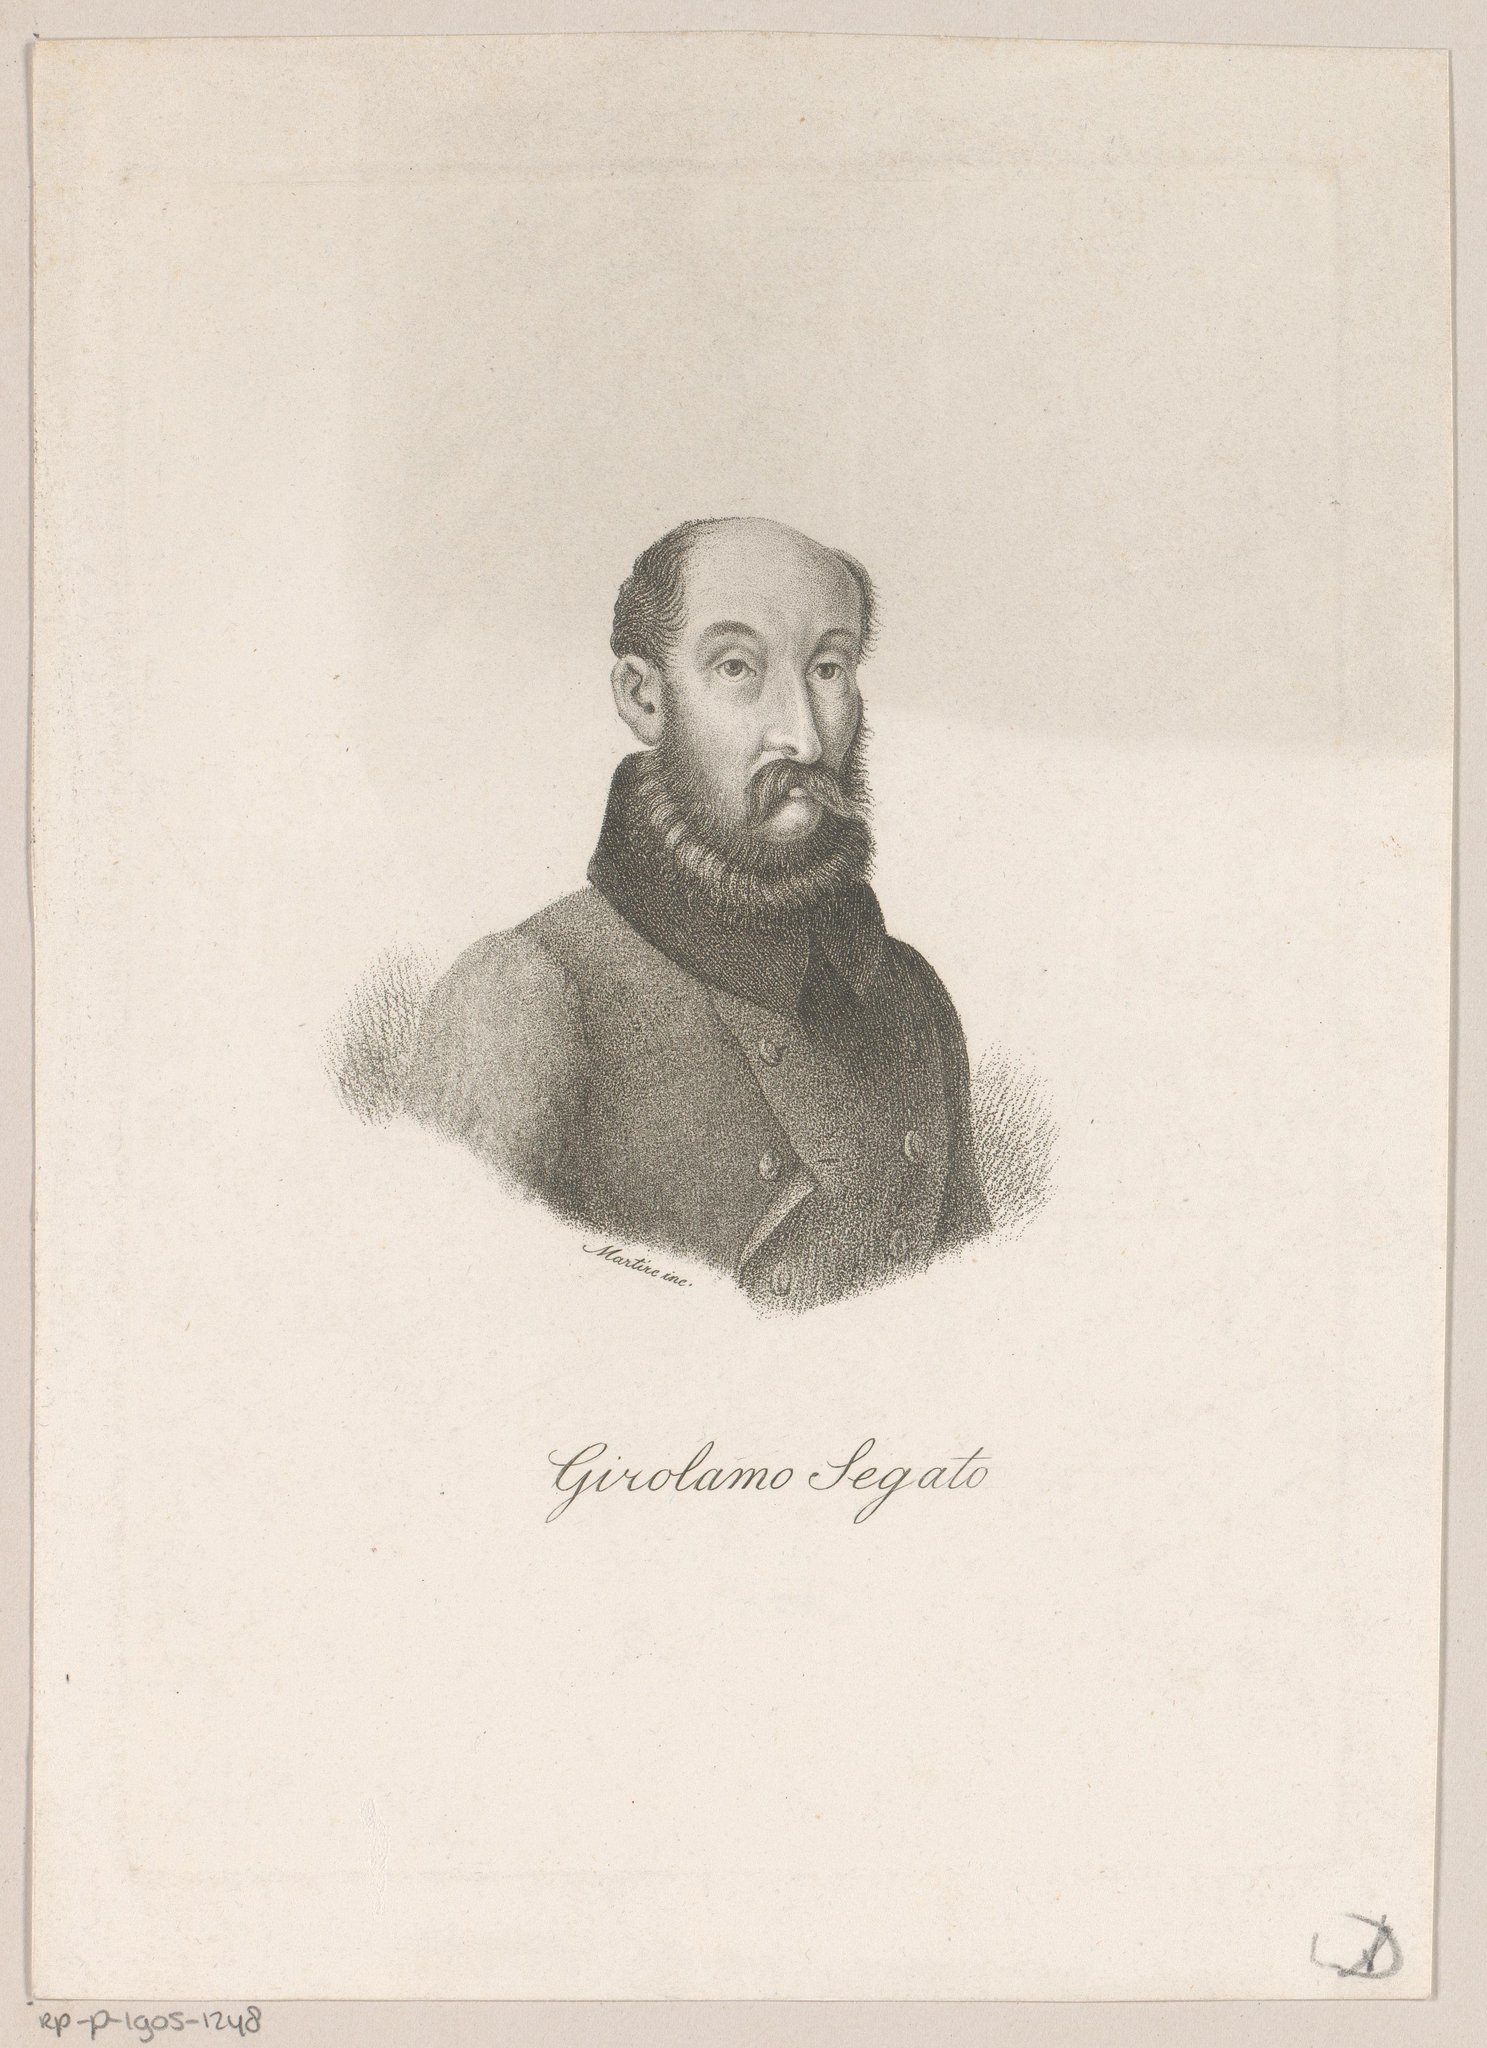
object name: print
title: Portret van Girolamo Segato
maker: sante martire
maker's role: print maker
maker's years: 1771-1851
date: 1822-1851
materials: paper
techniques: printmaking, etching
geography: italy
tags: physicist, historical persons, physiology and anatomy (+ portrait of scholar, scientist), science and technology (+ portrait of scholar, scientist)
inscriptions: collector's mark: Lugt 2228